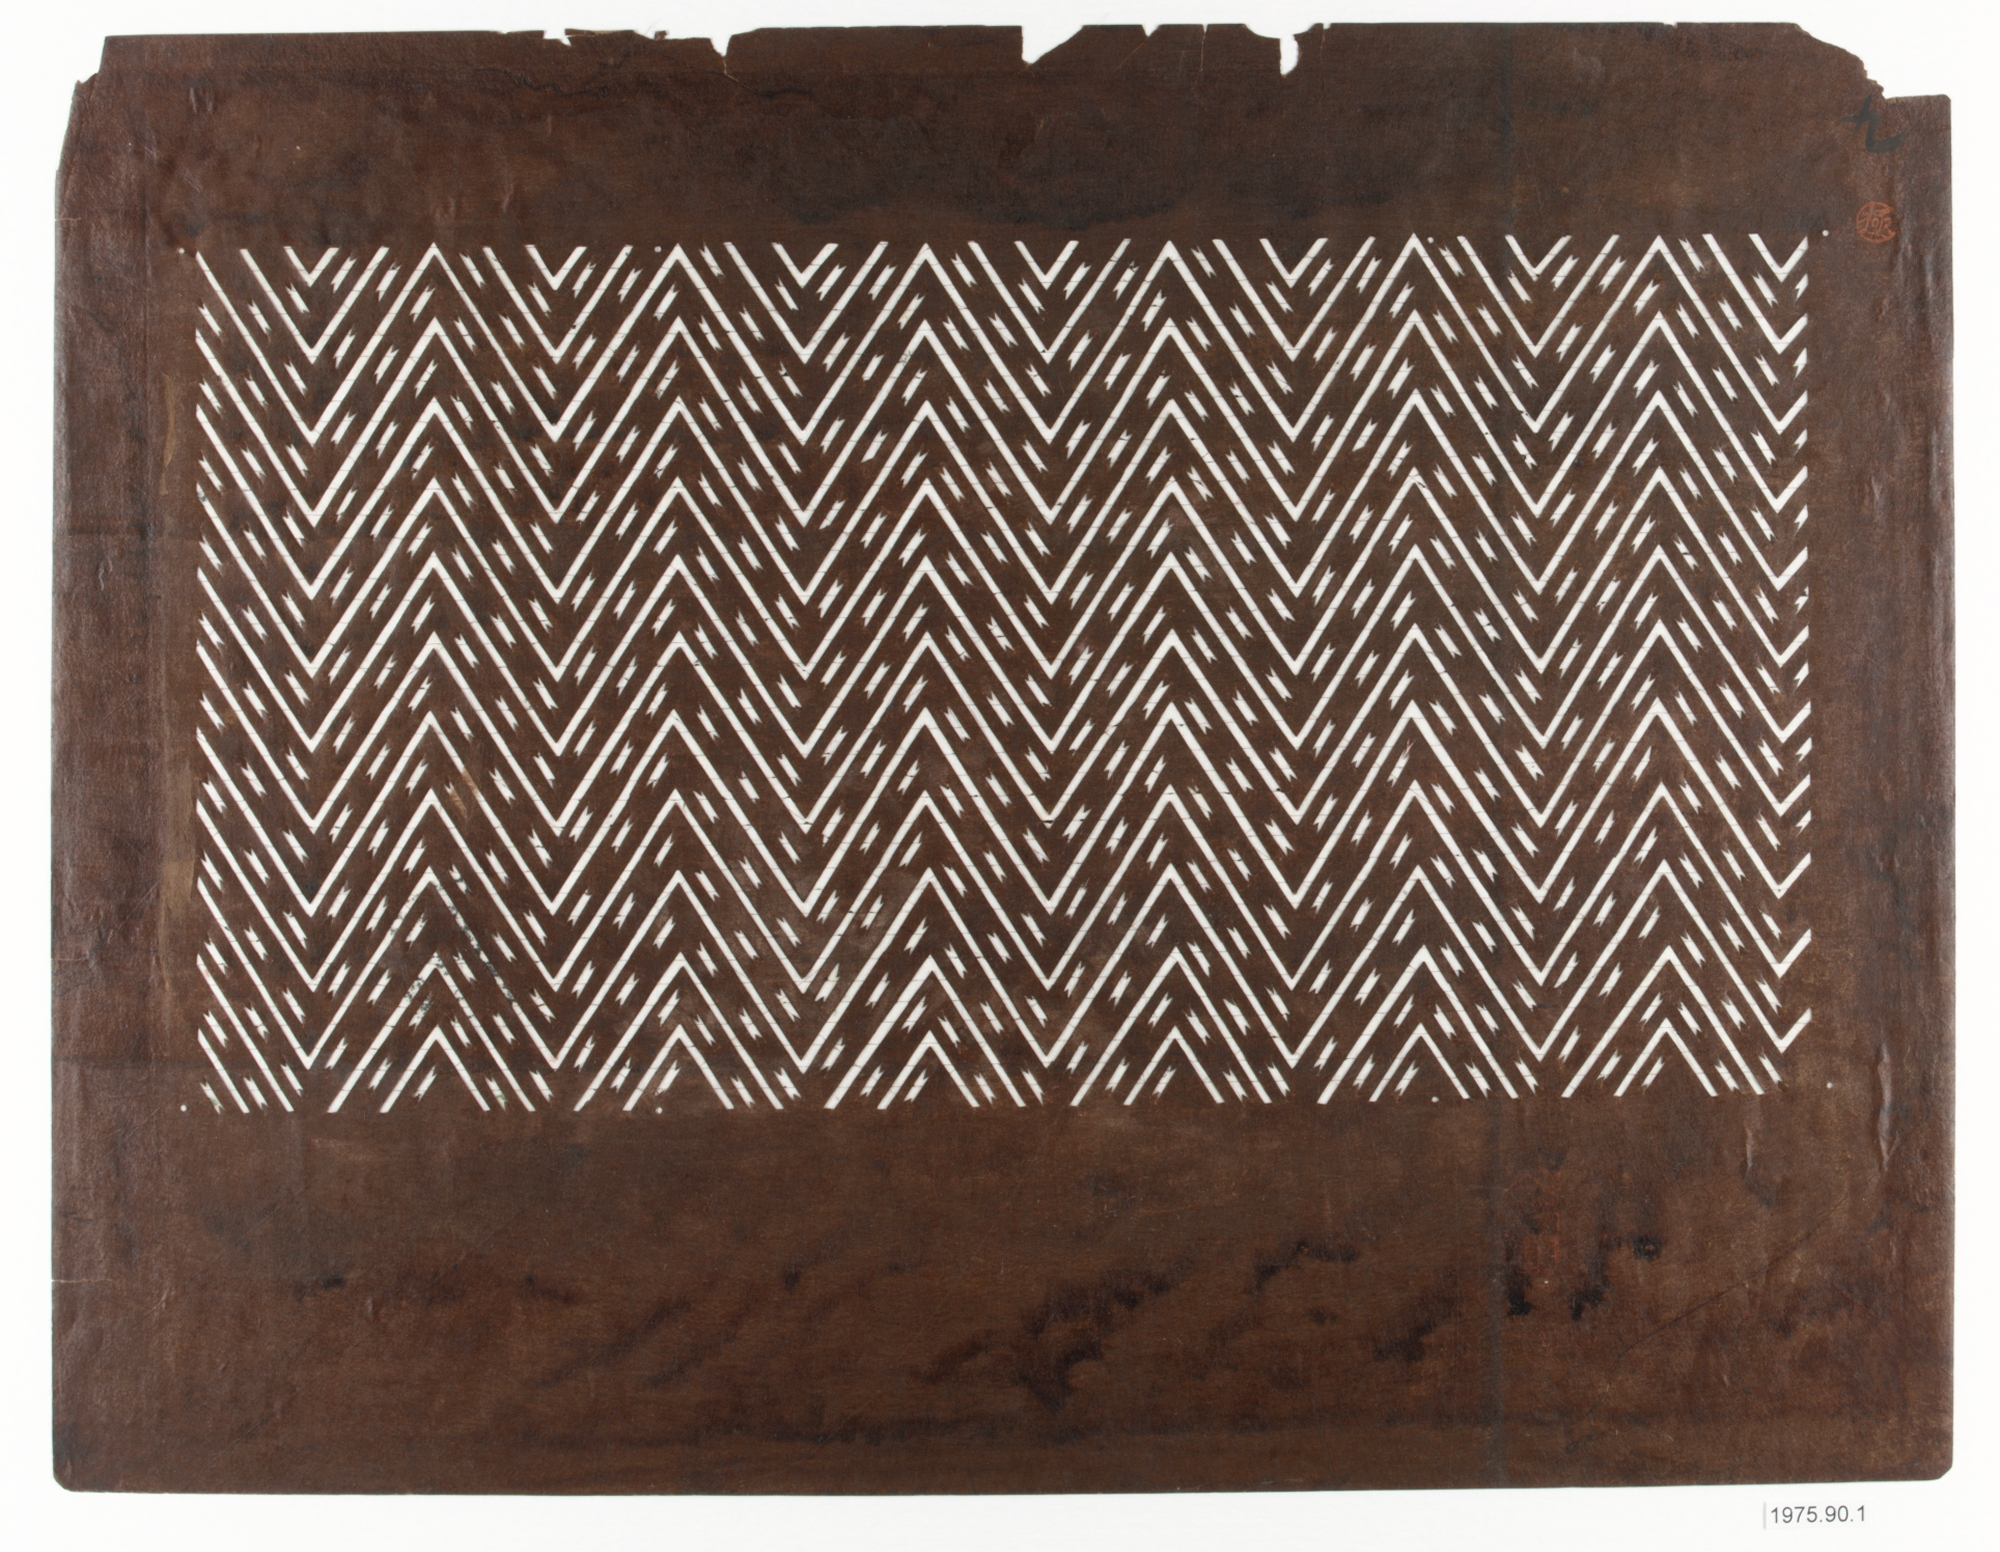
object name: stencil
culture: japanese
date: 1867-1933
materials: paper, silk